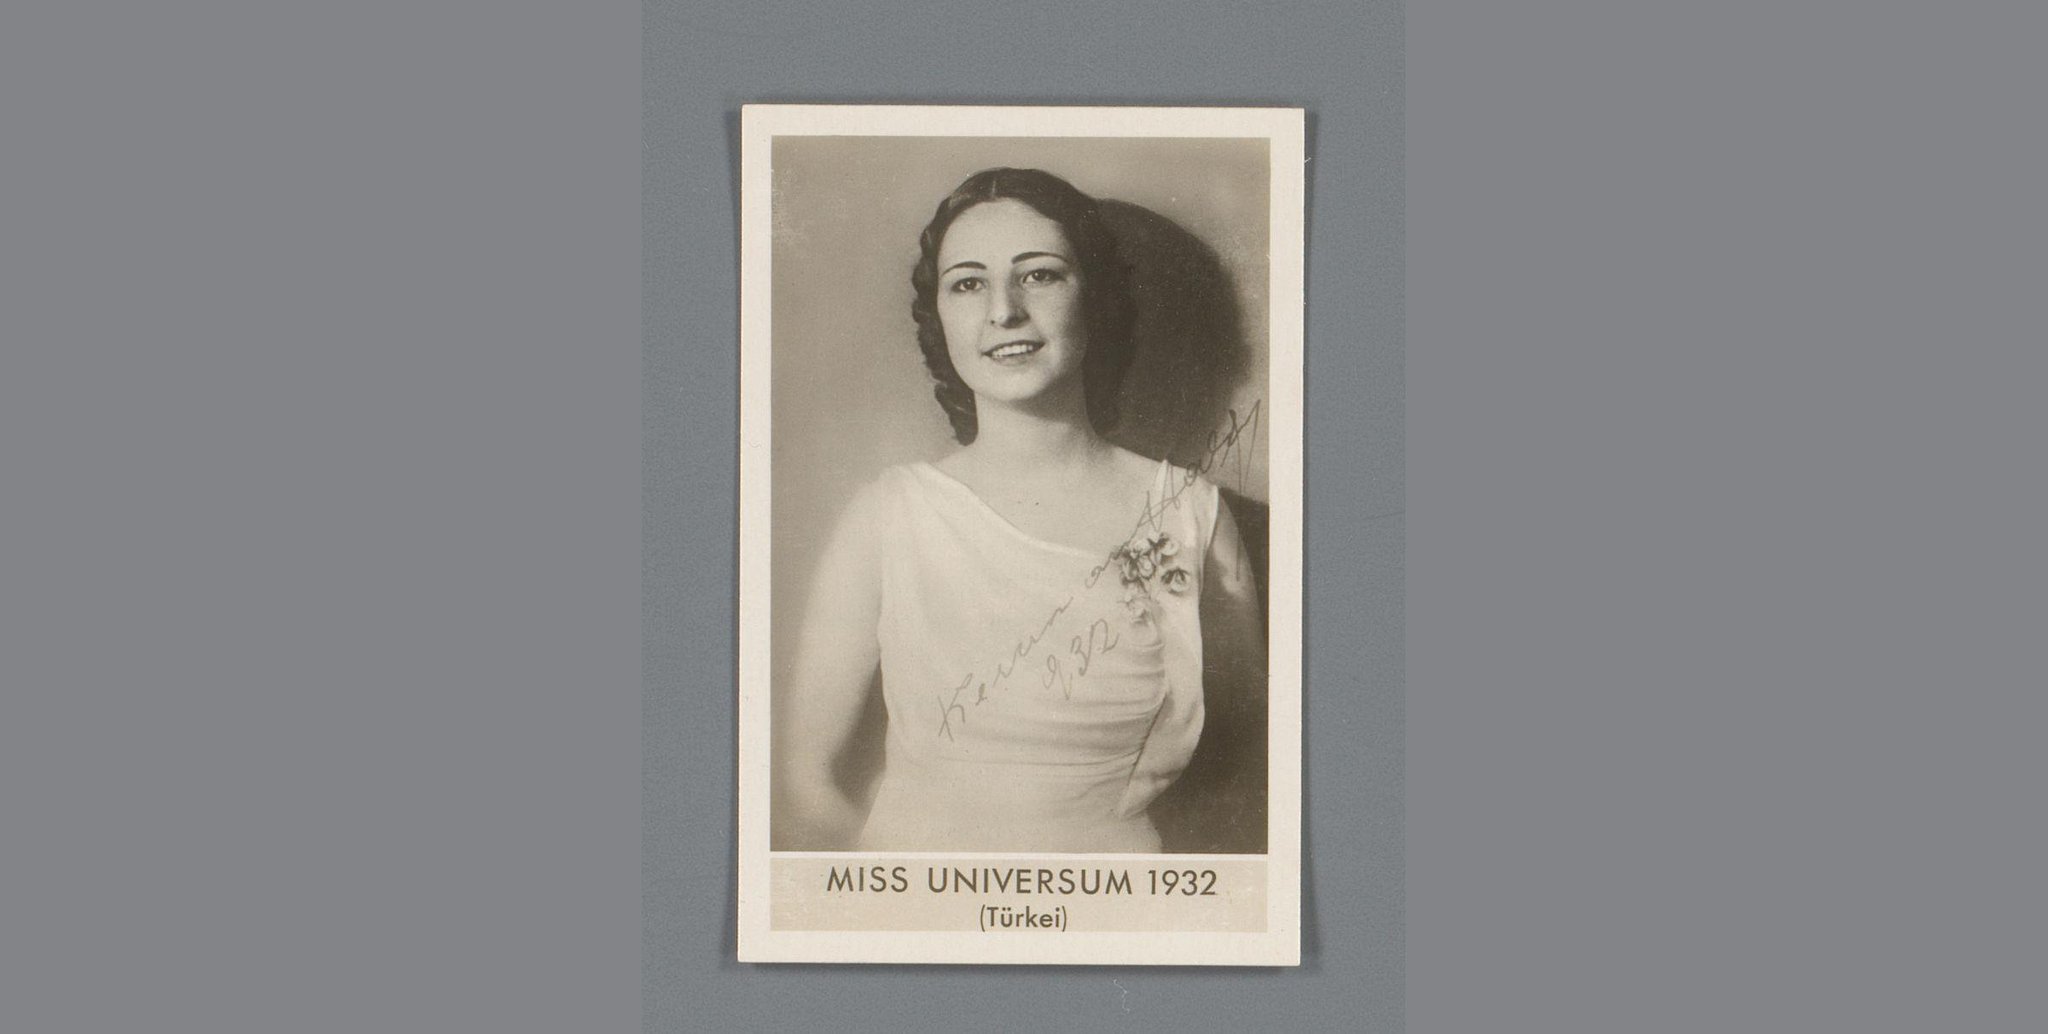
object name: photograph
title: Miss Universum 1932 (Türkei)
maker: Anonymous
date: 1932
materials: paper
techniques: gelatin silver print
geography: dresden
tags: historical persons - bb - woman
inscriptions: inscription: ‘Die schönsten/ Frauen der Welt/ dargestellt durch die Schön-/ heitsköniginnen aller Länder,/ finden Sie in 190 echten/ Bromsilber-Fotos, die nur den/ CLUB-und-LIGA-Packun-/ gen beiliegen. Eind prächtiges/ Sammel-Album erhalten Sie/ für 75 Pfennig vom Händler/ oder bei Einsendung von/ 75 Pfennig in Briefmarken/ von der Bilderstelle Lohse,/ Dresden A24, Nossener Str. 1./ Ges. gesch. Nachdruck verboten!’